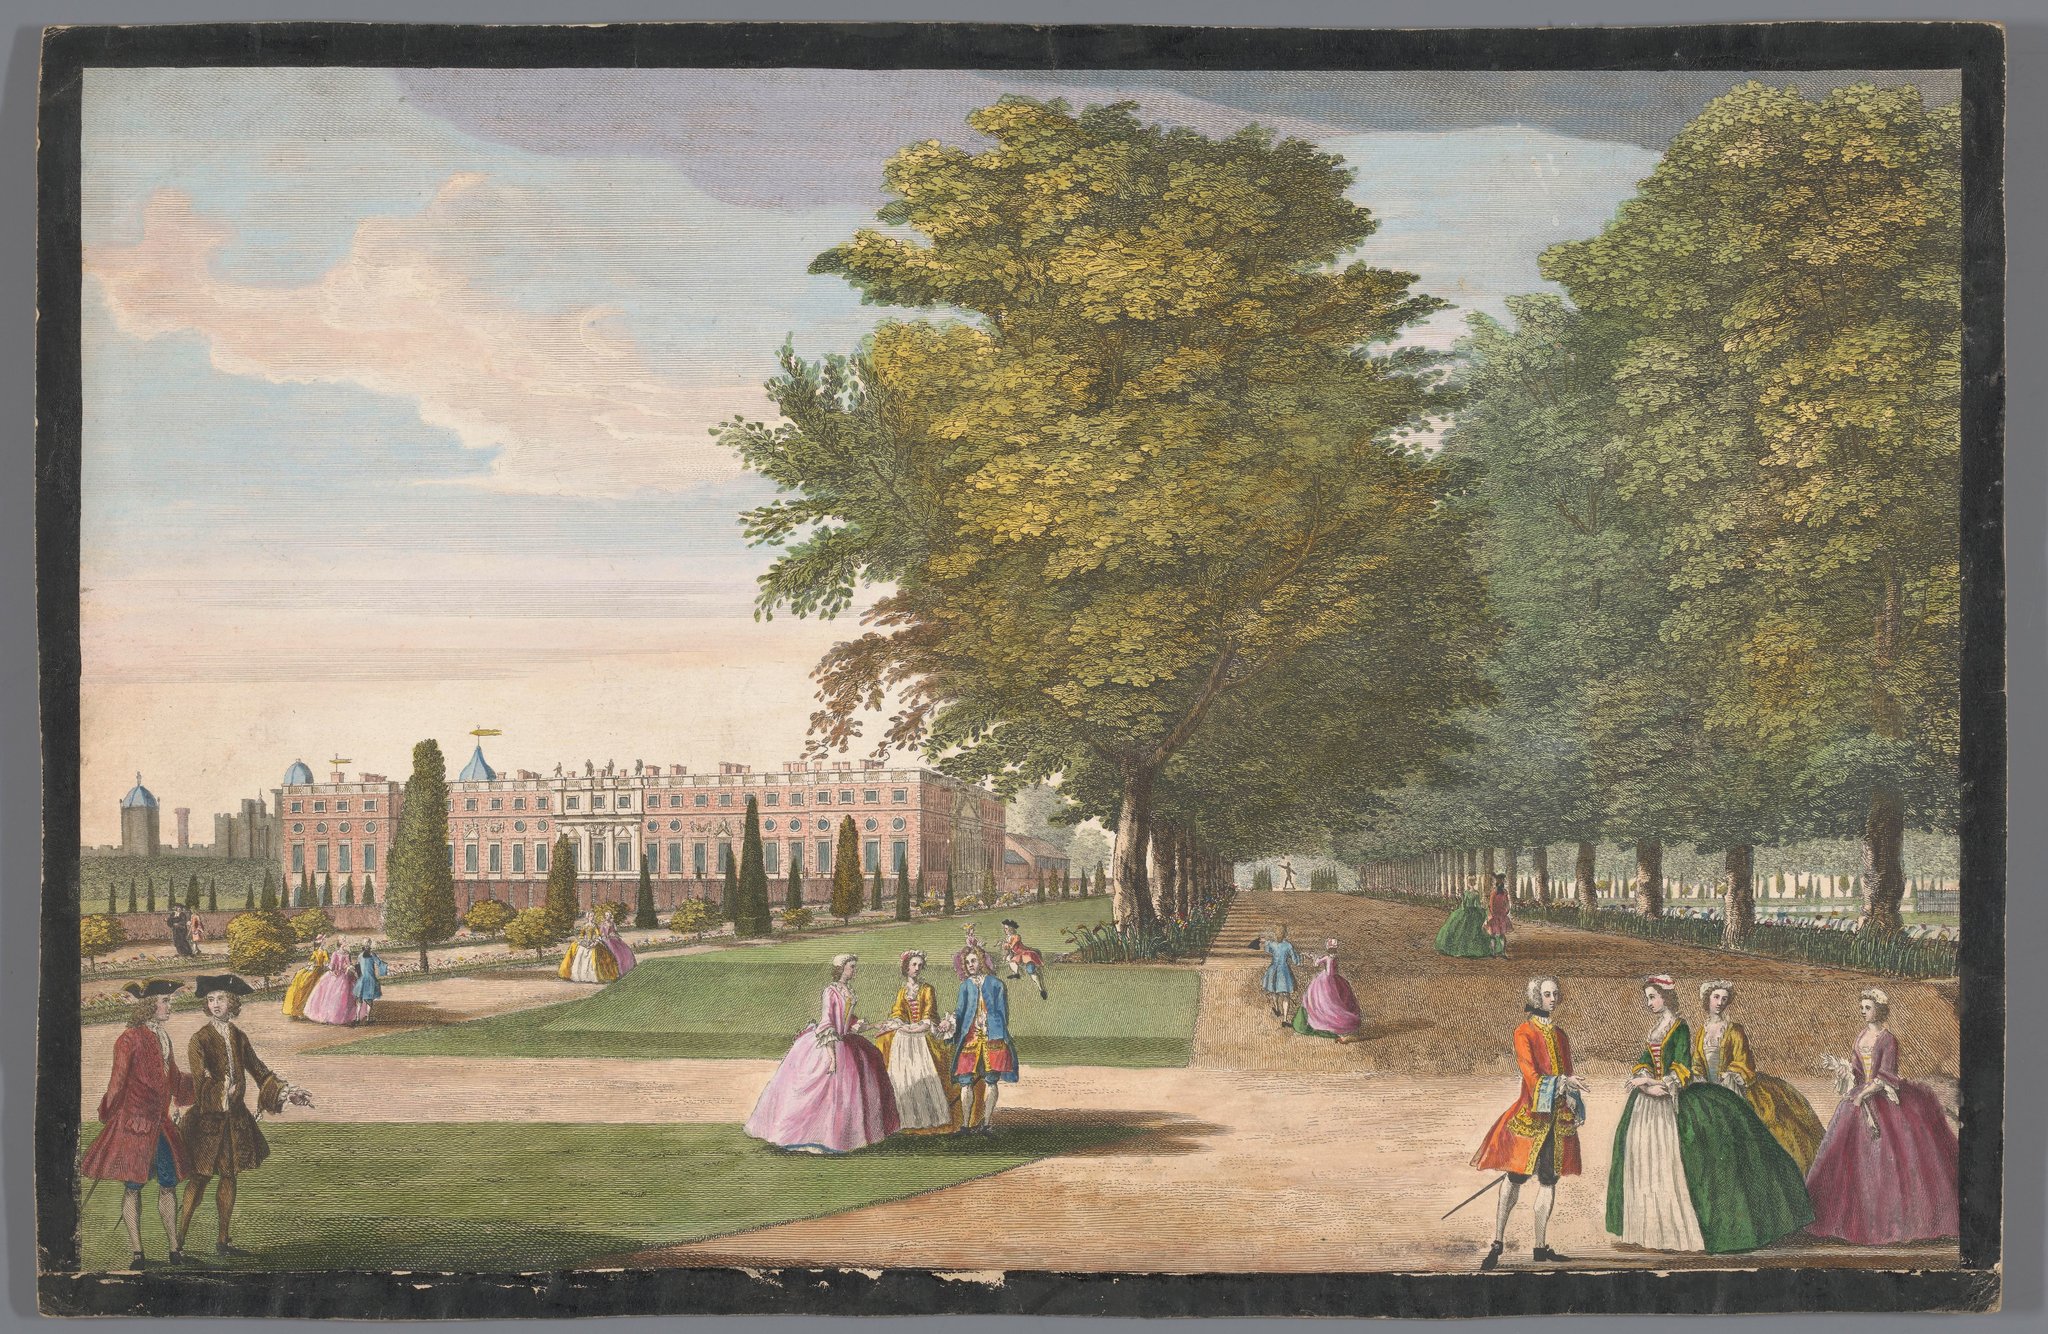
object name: print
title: Gezicht op Hampton Court Palace te Londen gezien vanaf de zuidzijde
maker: Anonymous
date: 1700-1799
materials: cardboard, paper, watercolor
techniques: brush, etching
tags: garden, palace